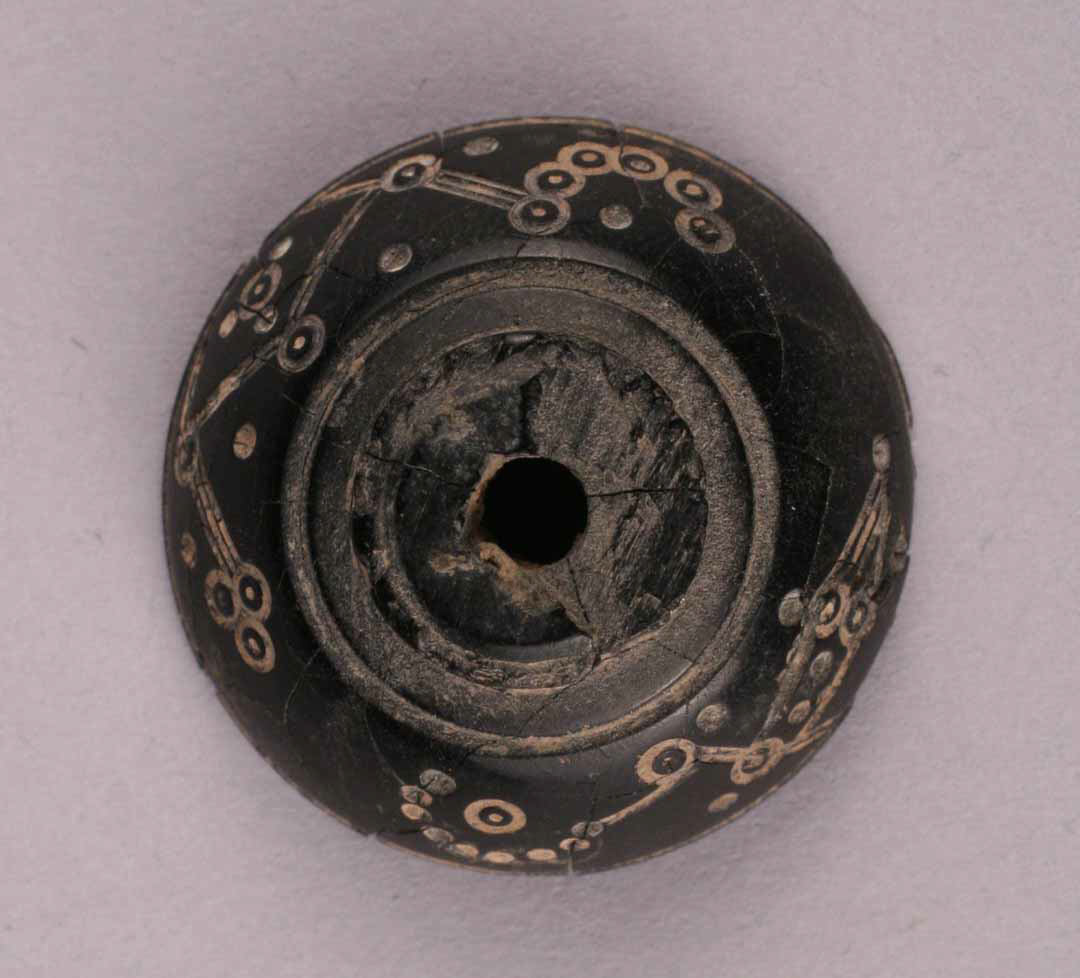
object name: button or bead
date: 801-1000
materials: paste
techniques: carving, incising, inlay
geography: iran